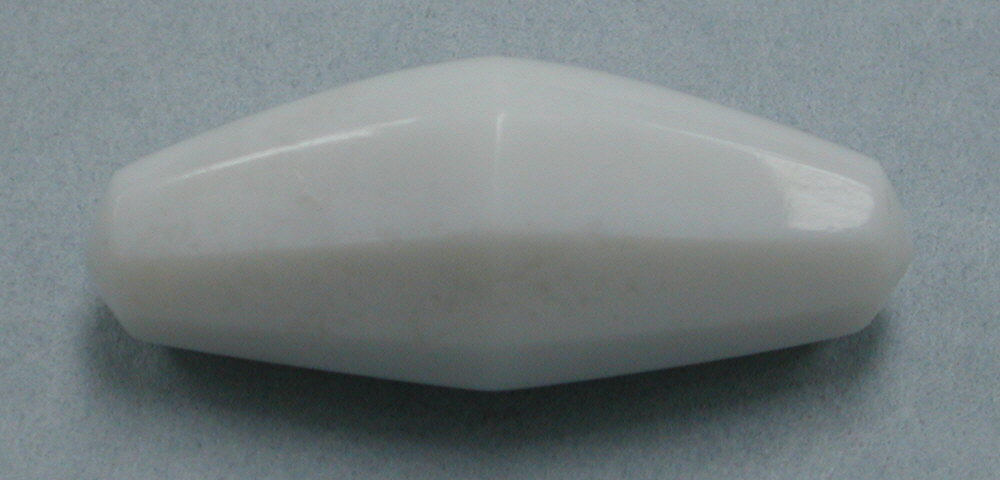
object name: ritual stone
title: Polishing Stone (pulidor)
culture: mexican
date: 1501-1600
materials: stone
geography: mexico